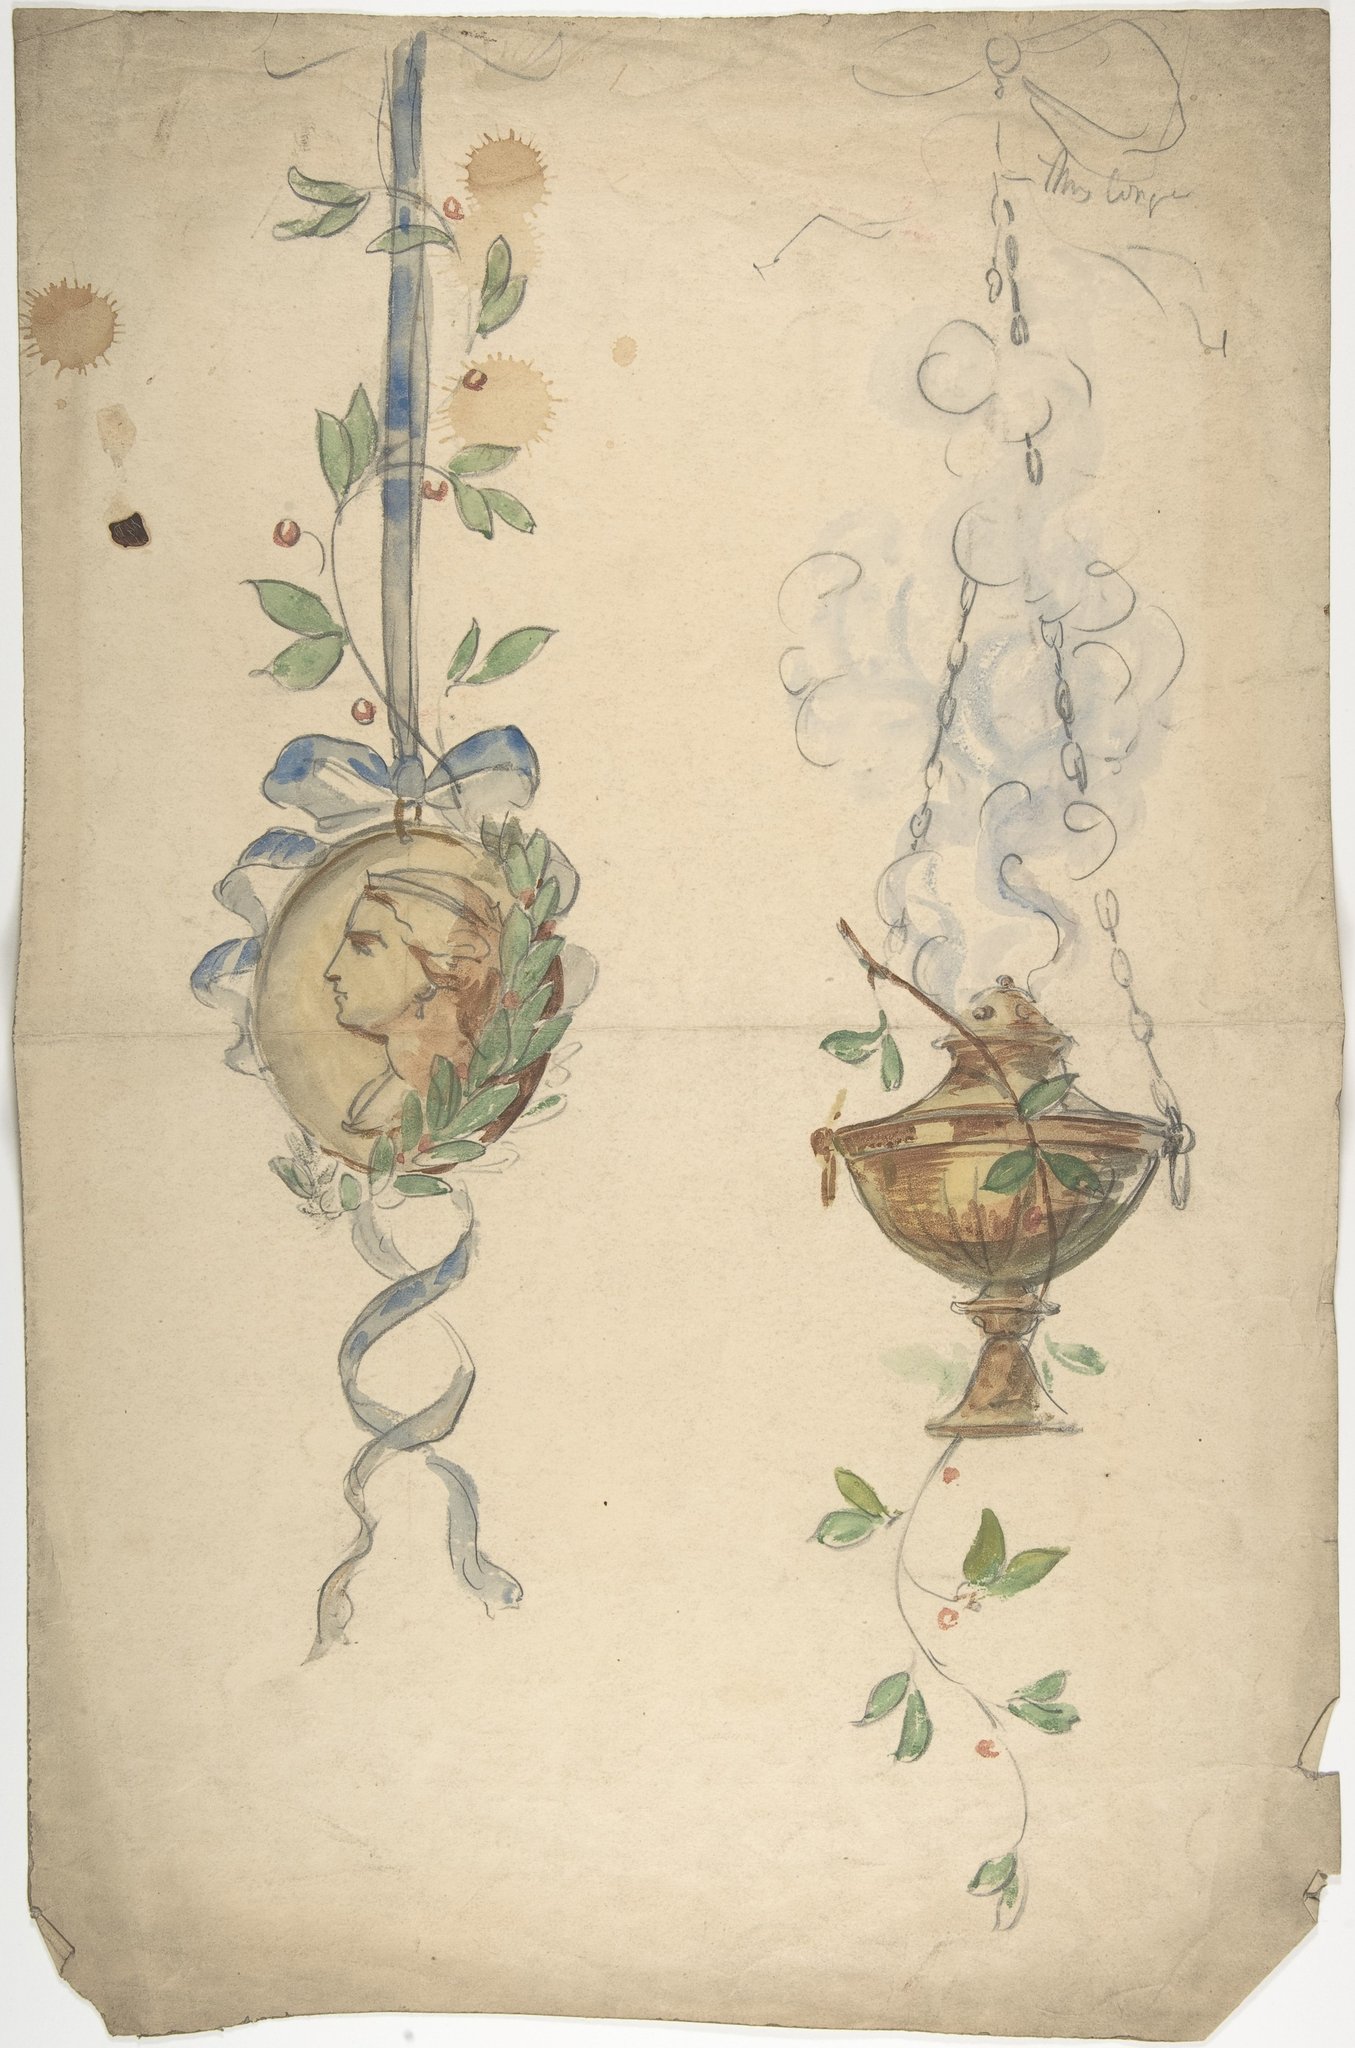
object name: drawing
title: Designs for Trophies Containing Medallion and Urn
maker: anonymous, british, 19th century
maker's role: artist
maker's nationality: british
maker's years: 1800-1900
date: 1801-1900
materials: ink, watercolor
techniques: pen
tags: medallions,profiles,leaves,urns